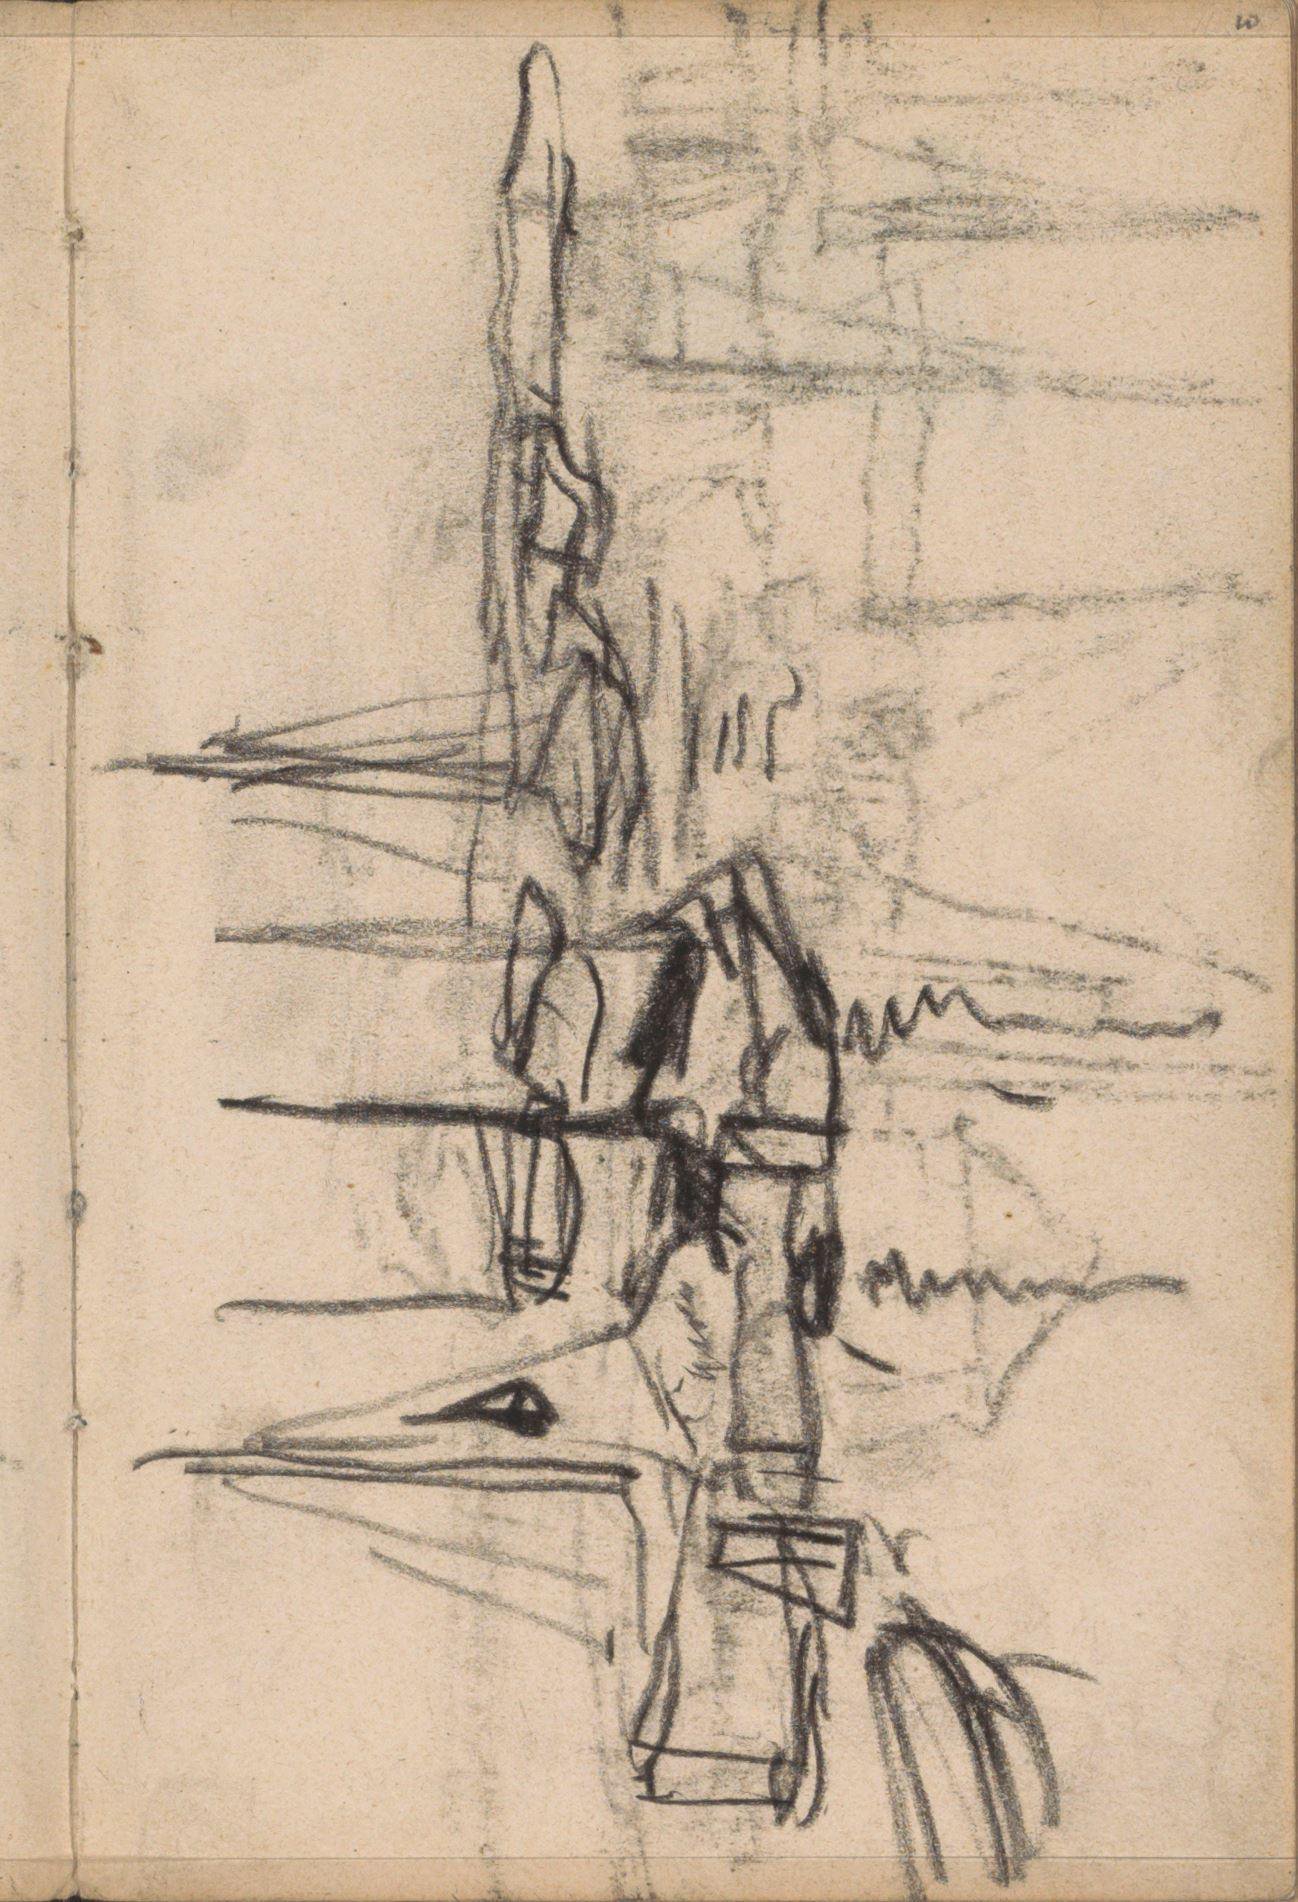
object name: sketchbook leaf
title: Schepen bij de Barentszkade te Amsterdam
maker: george hendrik breitner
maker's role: draughtsman, painter, print maker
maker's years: 1857-1923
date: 1892-1923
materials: chalk, paper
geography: amsterdam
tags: ships (in general), quay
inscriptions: kleurnotitie, handgeschreven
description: Schepen bij de Barentszkade te Amsterdam. Pagina 10 uit een schetsboek met 45 bladen vervaardigd te Schwerin en Amsterdam.